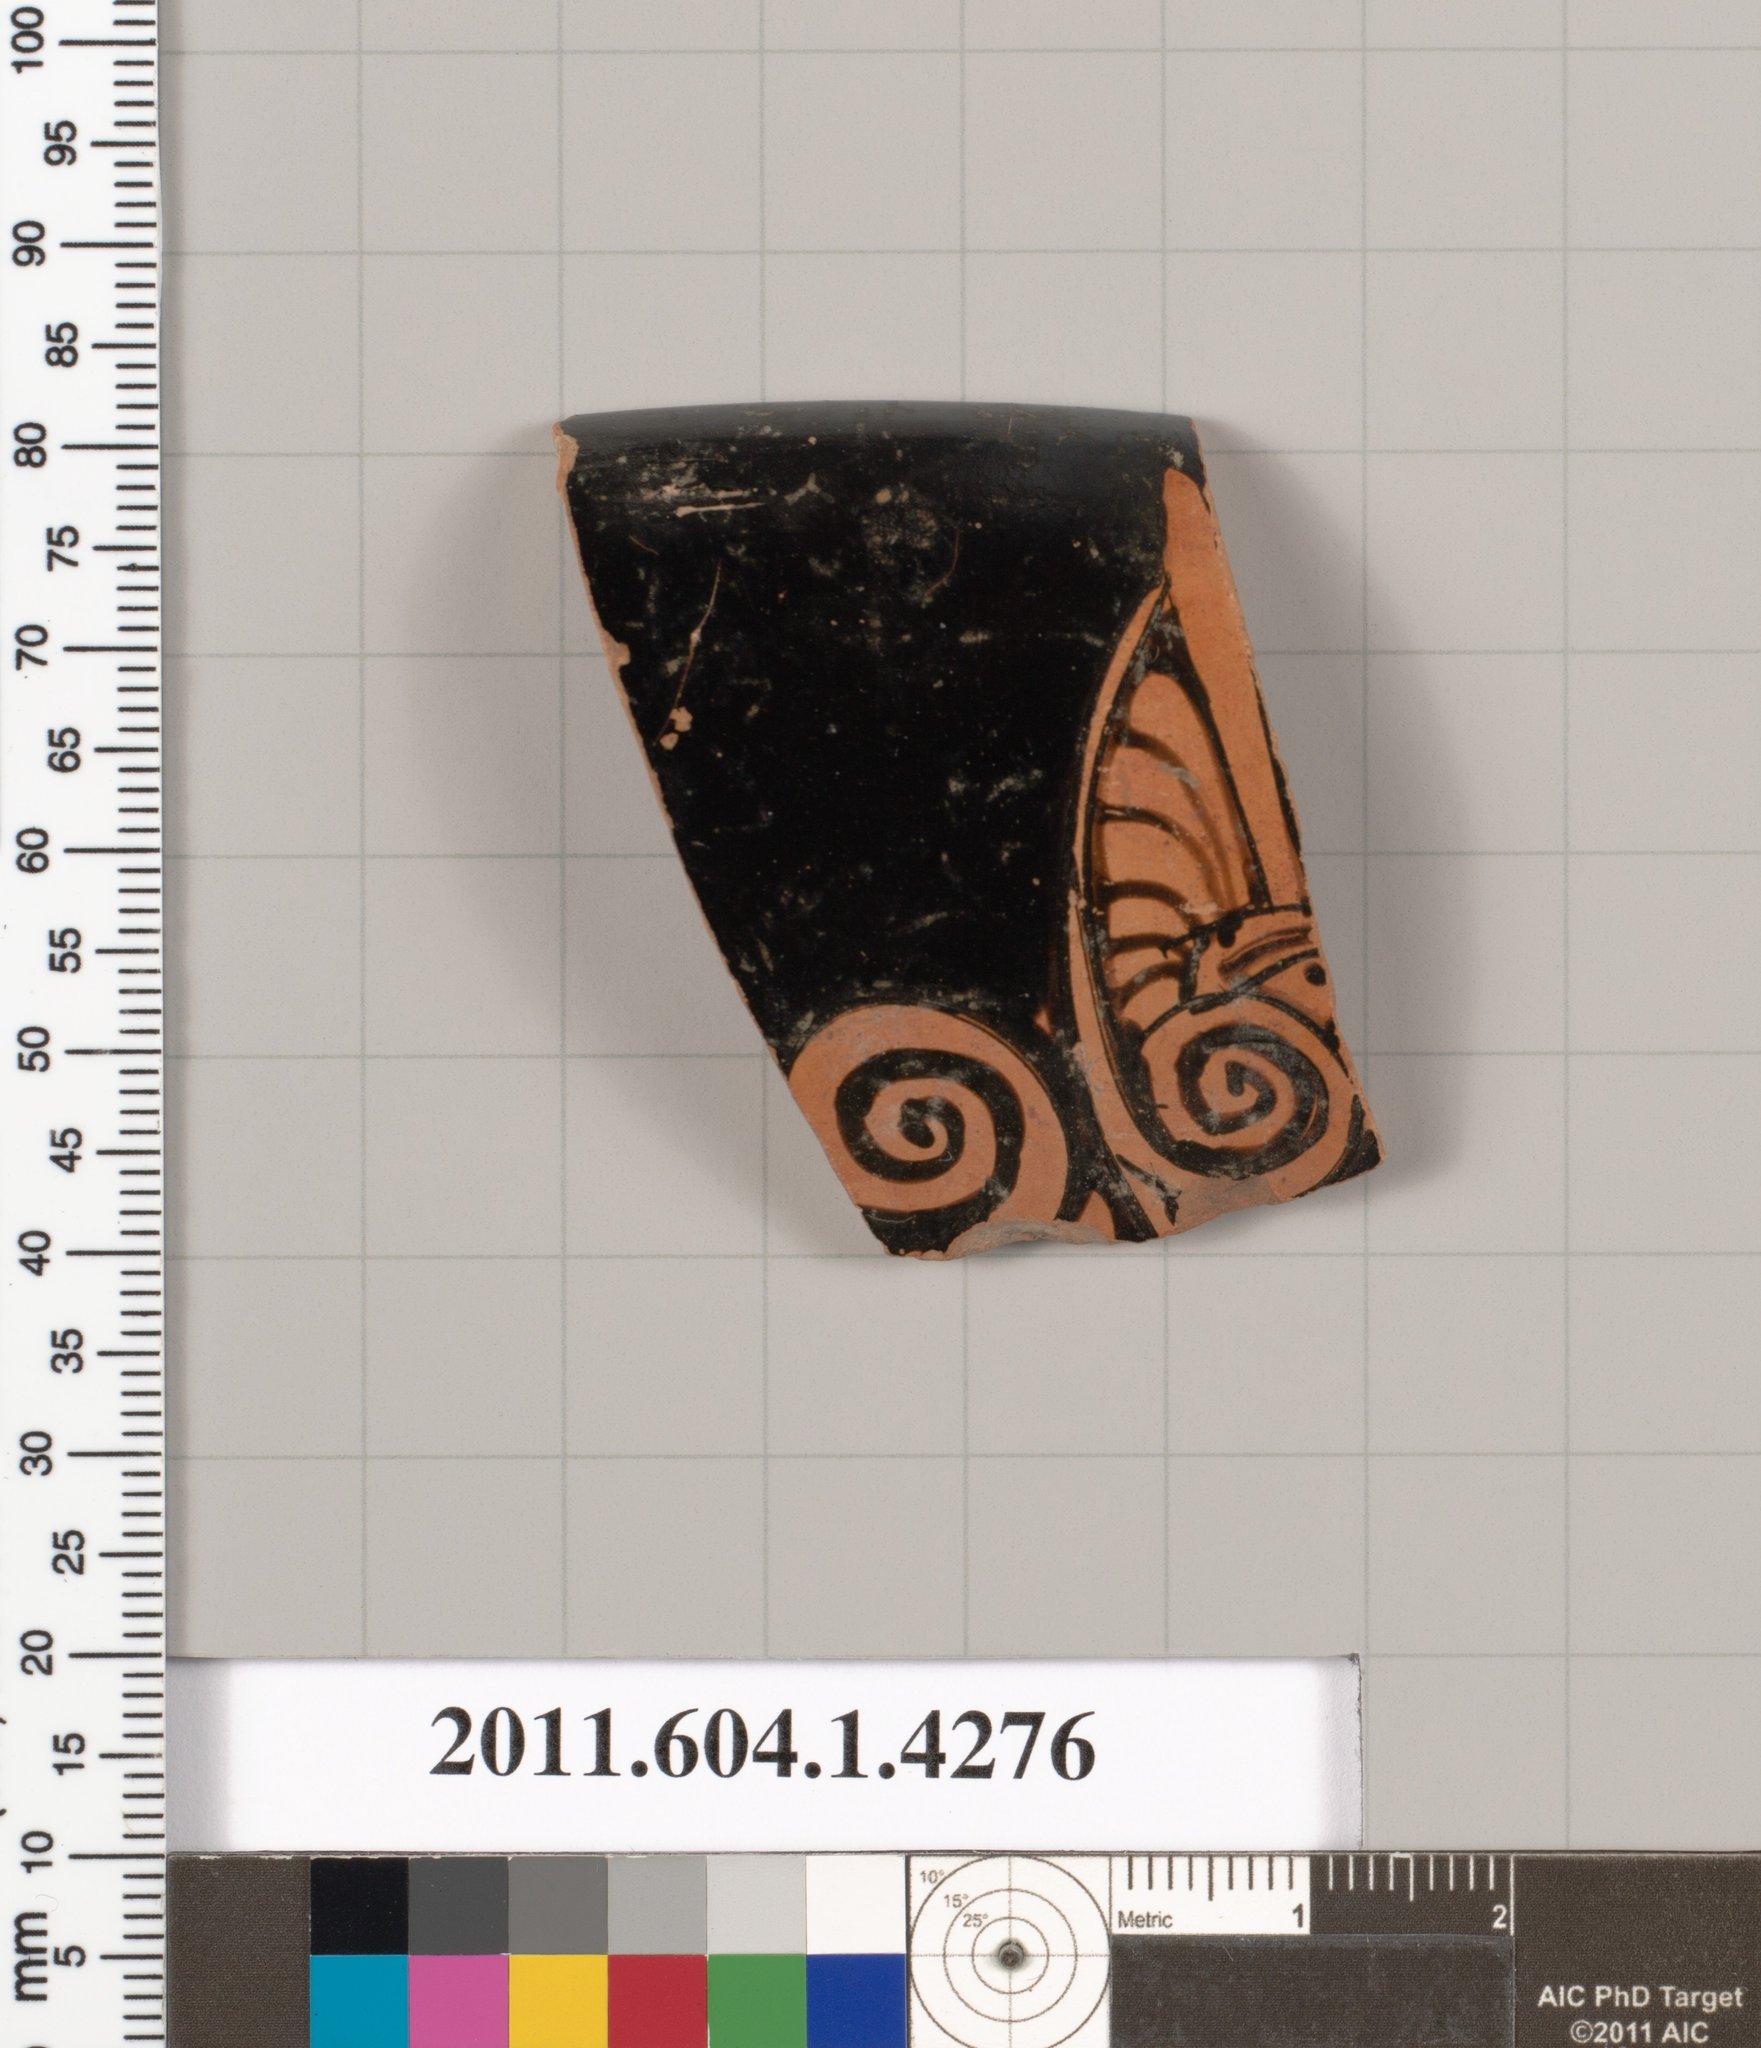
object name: kylix fragment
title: Terracotta rim fragment of kylix (drinking cup)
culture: greek, attic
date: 470-440 BCE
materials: terracotta